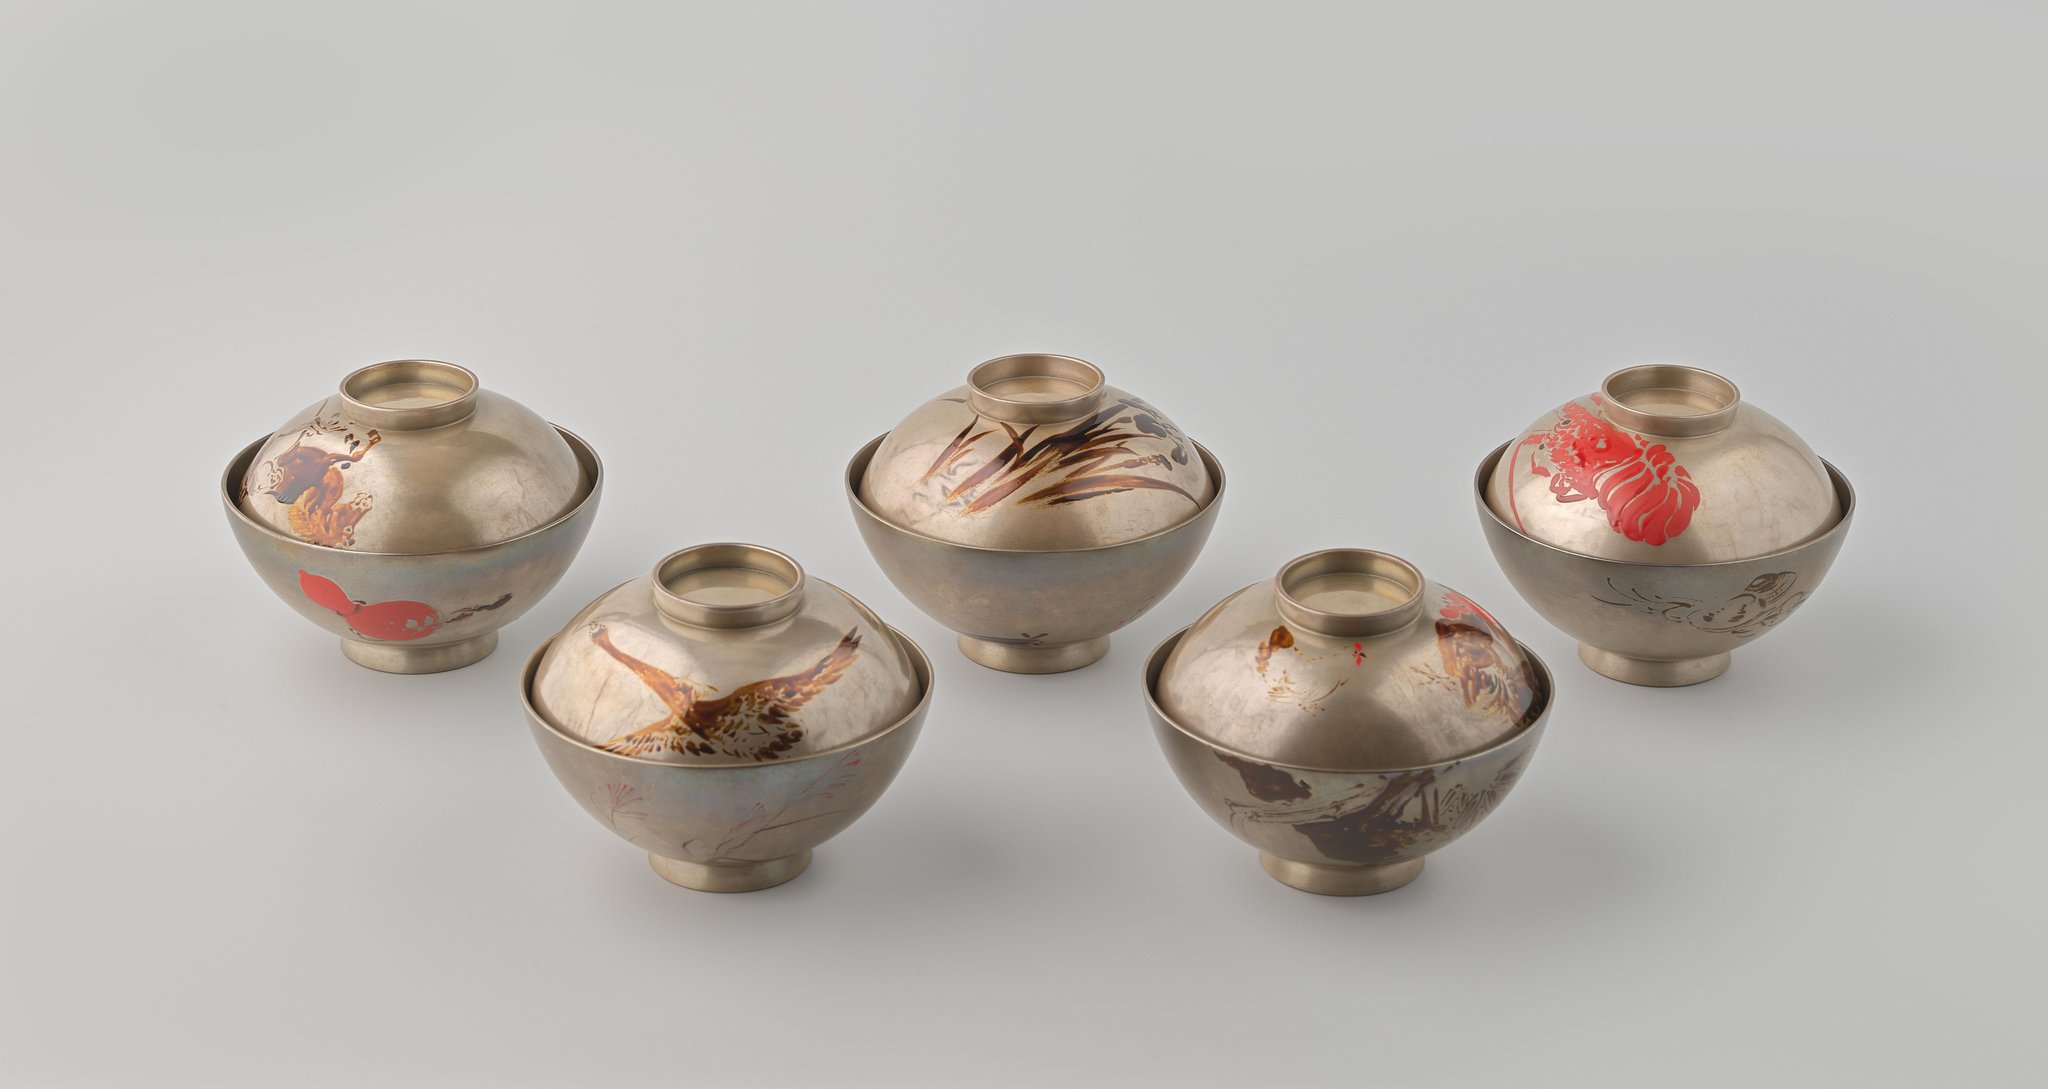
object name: bowl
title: Set of five silver lacquer bowls with decoration in lacquer painting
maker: tanaka ikka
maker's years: 1864-1924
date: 1920-1945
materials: lacquer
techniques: lacquer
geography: japan